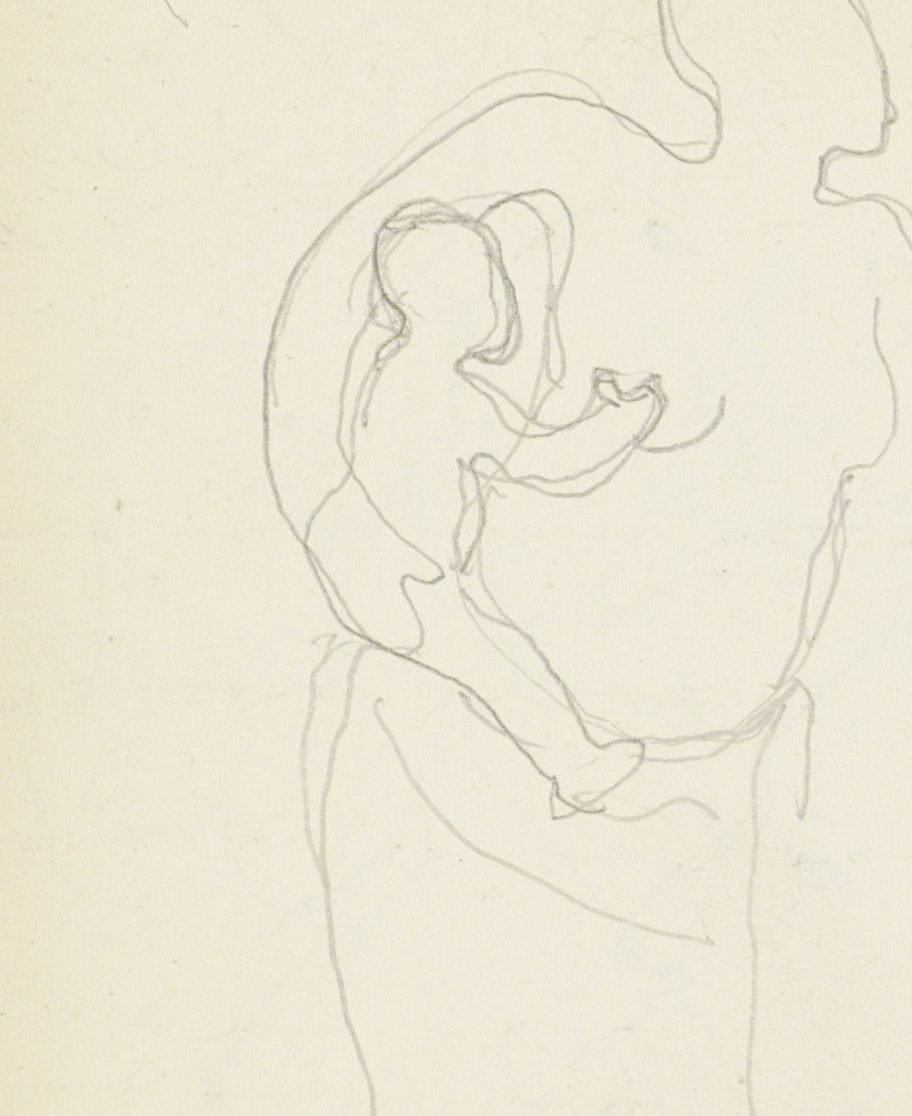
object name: sketchbook leaf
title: Afrikaanse vrouw met een kind op de heup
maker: reijer stolk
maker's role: draughtsman, print maker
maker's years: 1896-1945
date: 1916-1945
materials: paper, pencil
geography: africa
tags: carrying a child on the hip, astride, africans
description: Blad 30 verso uit een schetsboek met 60 bladen.